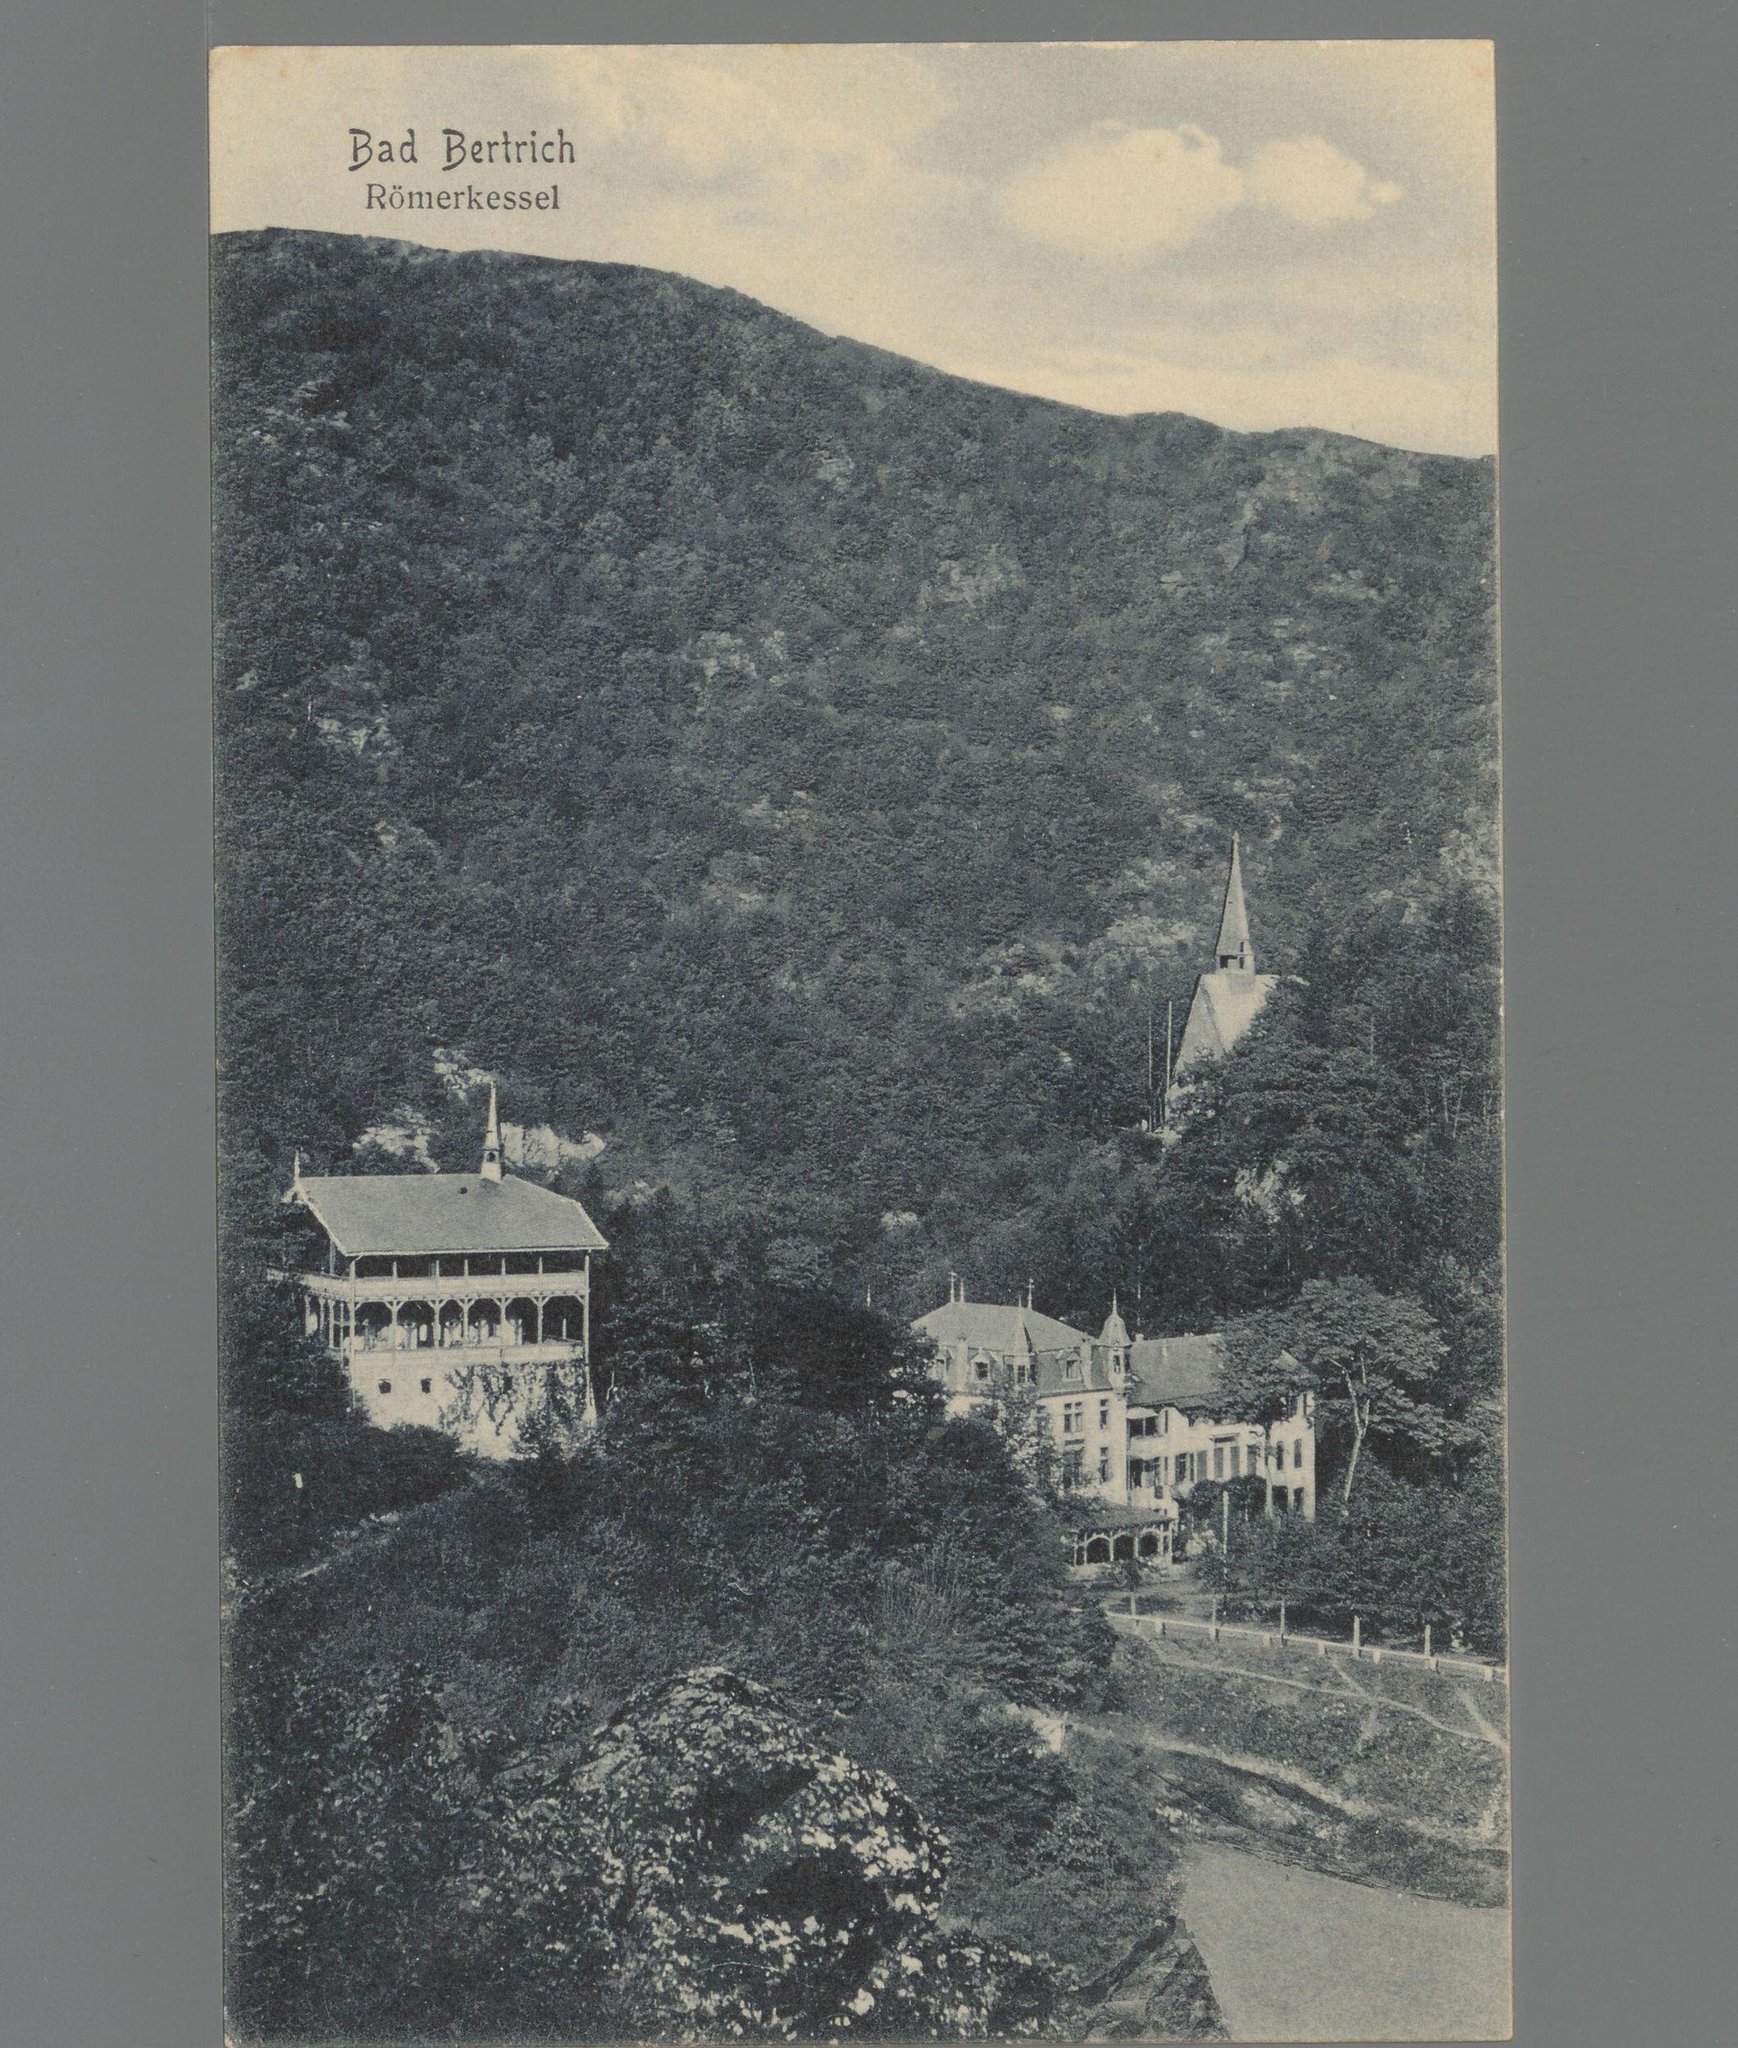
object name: ansichtkaart, prentbriefkaart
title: Bad Bertrich. Römerkessel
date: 1907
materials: cardboard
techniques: photograph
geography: bad bertrich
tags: city-view, and landscape with man-made constructions, mountains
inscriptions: date